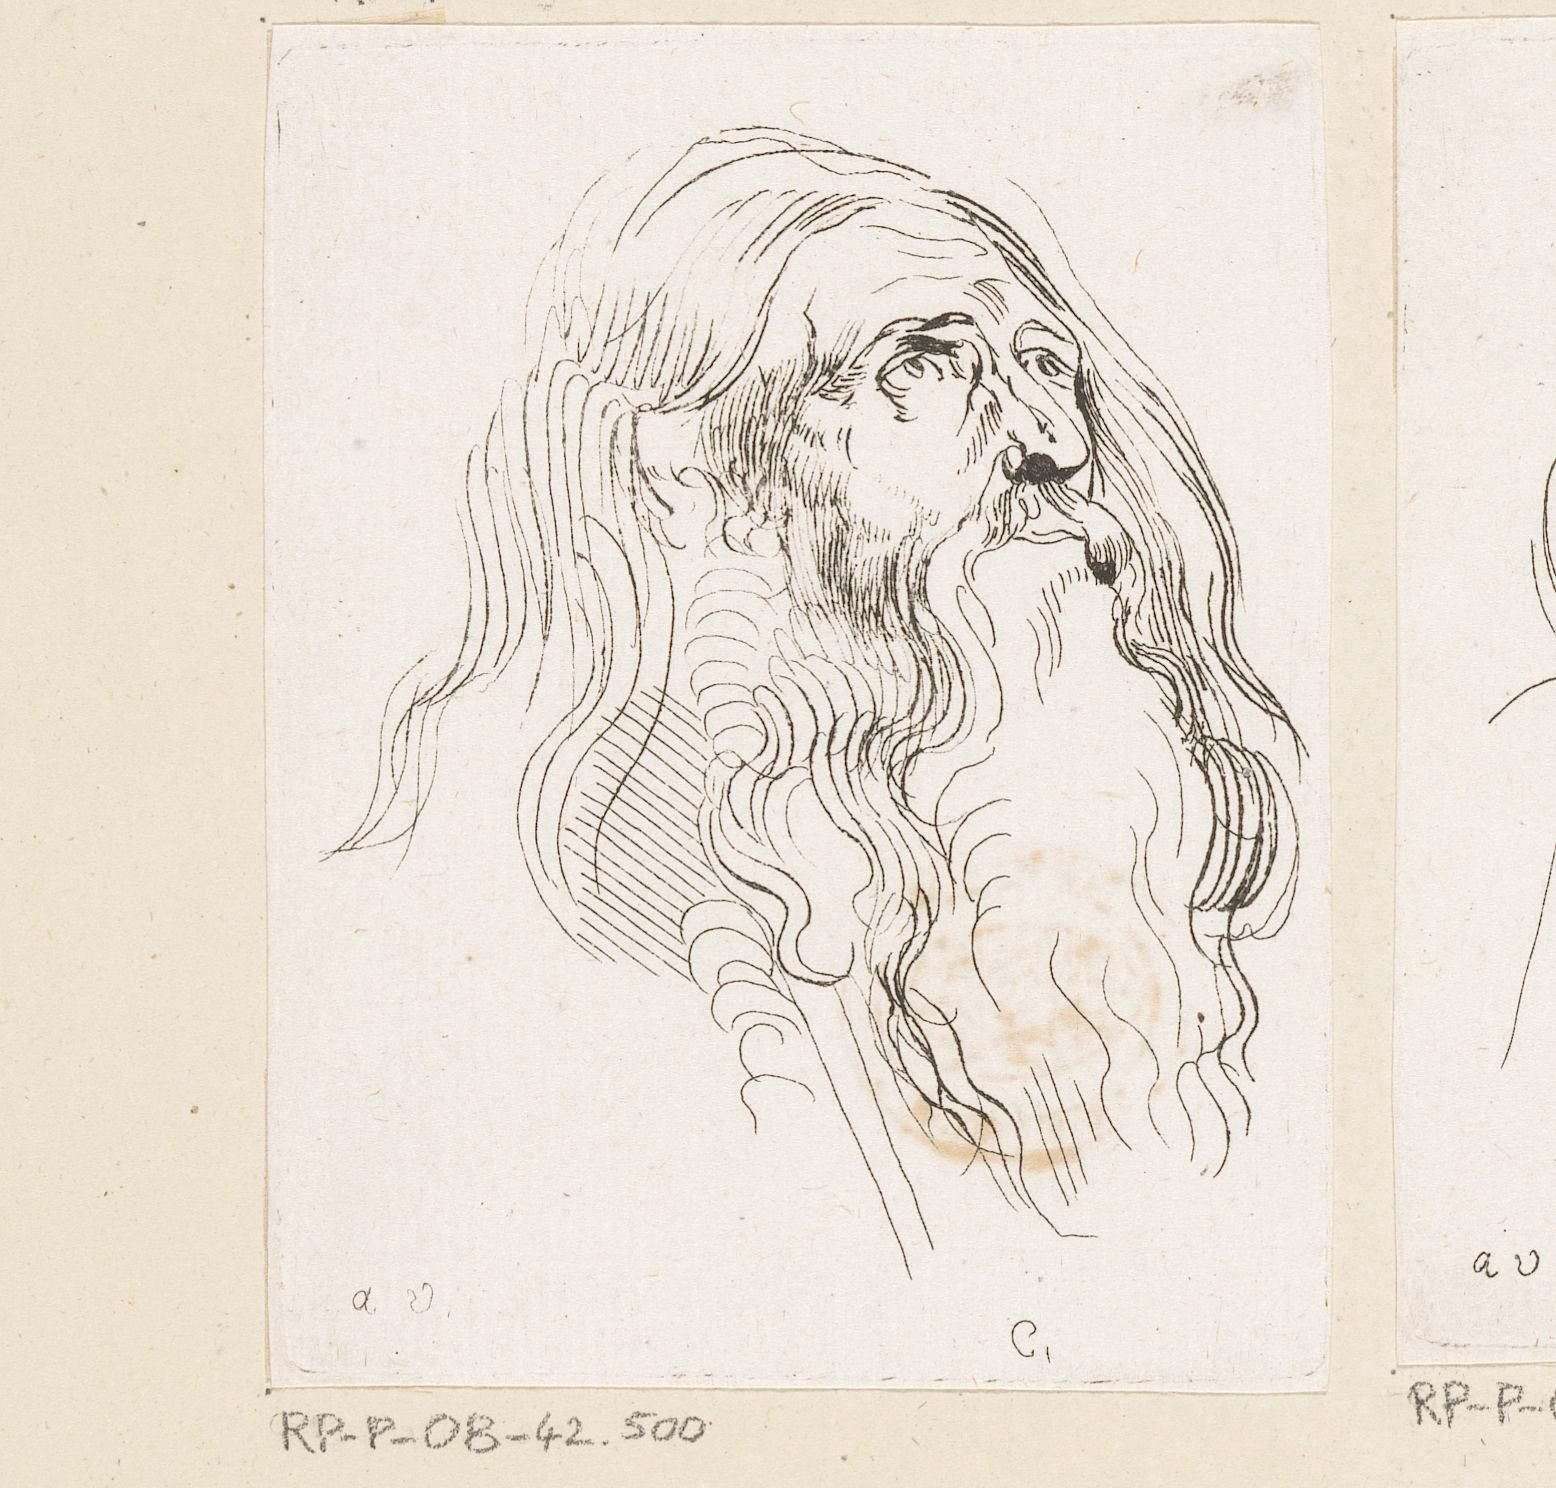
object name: print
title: Recueil de Testes d'Antoine Van Dyck (...)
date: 1735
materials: paper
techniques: etching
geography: france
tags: head (human), old man, beard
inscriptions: collector's mark: Lugt 240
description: Prent uit een serie van 31 prenten naar getekende hoofden door Van Dyck, plus een titelprent naar Bouchardon, getiteld: "Recueil de Testes d'Antoine Van Dyck tirées du Cabinet de M. Crozat et gravées par M. le C. de C.".